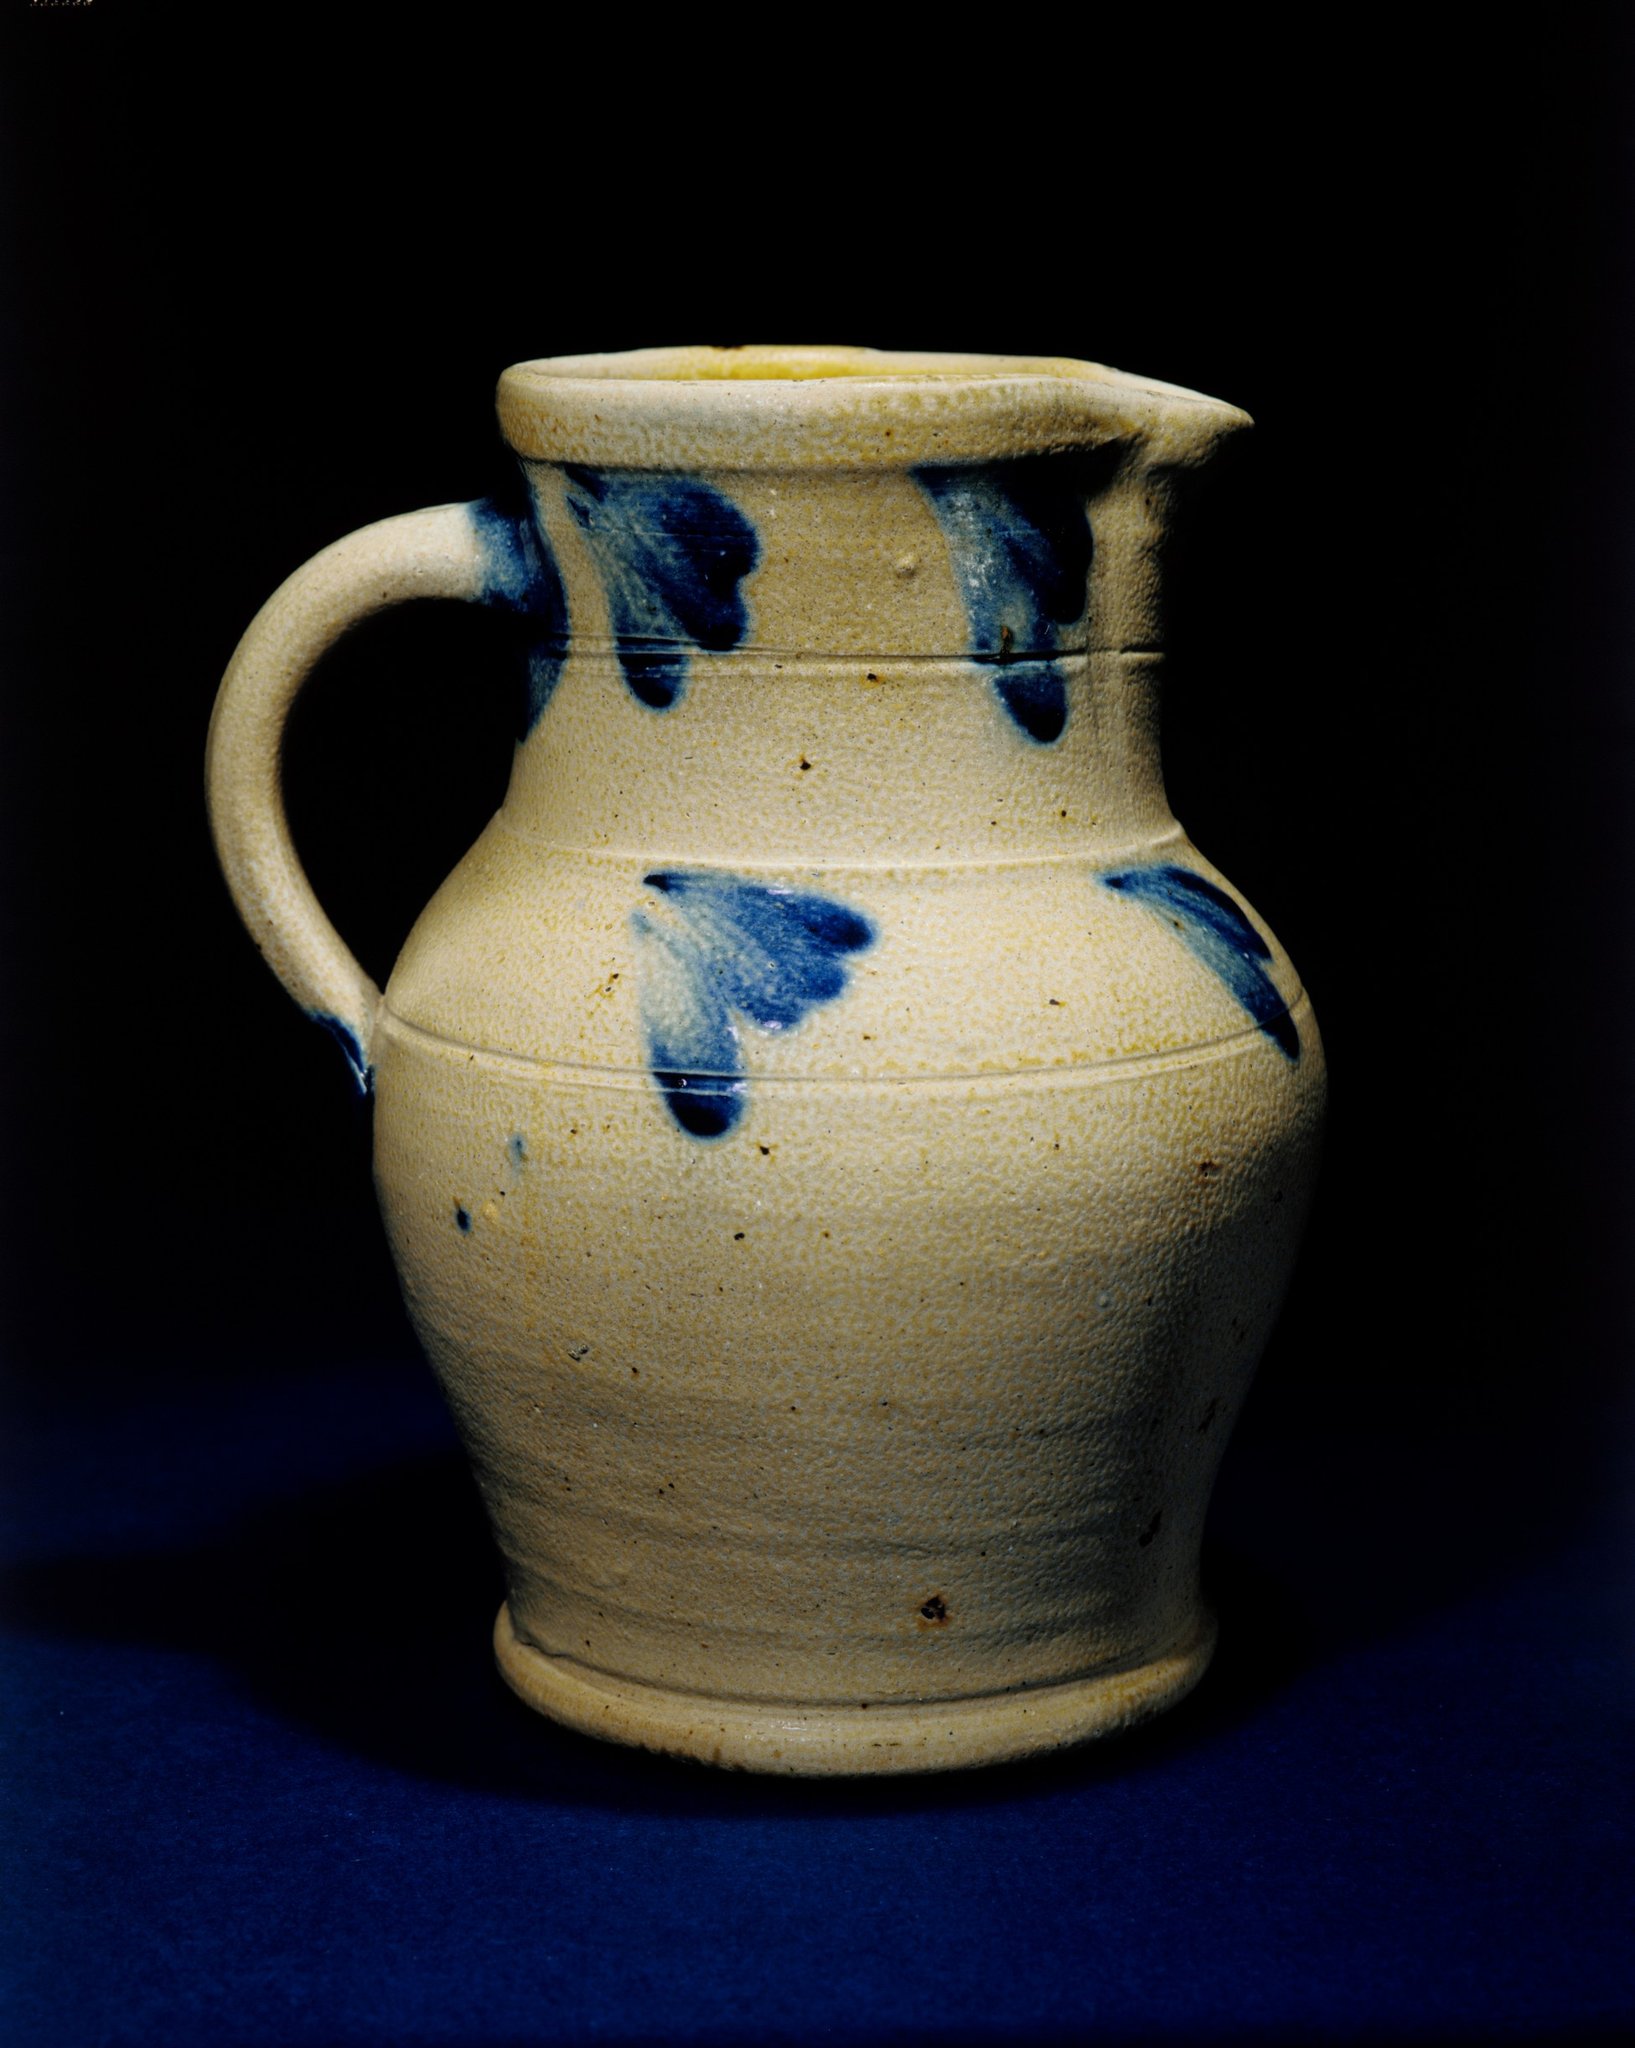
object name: pitcher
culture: american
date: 1800-1830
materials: stoneware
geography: united states